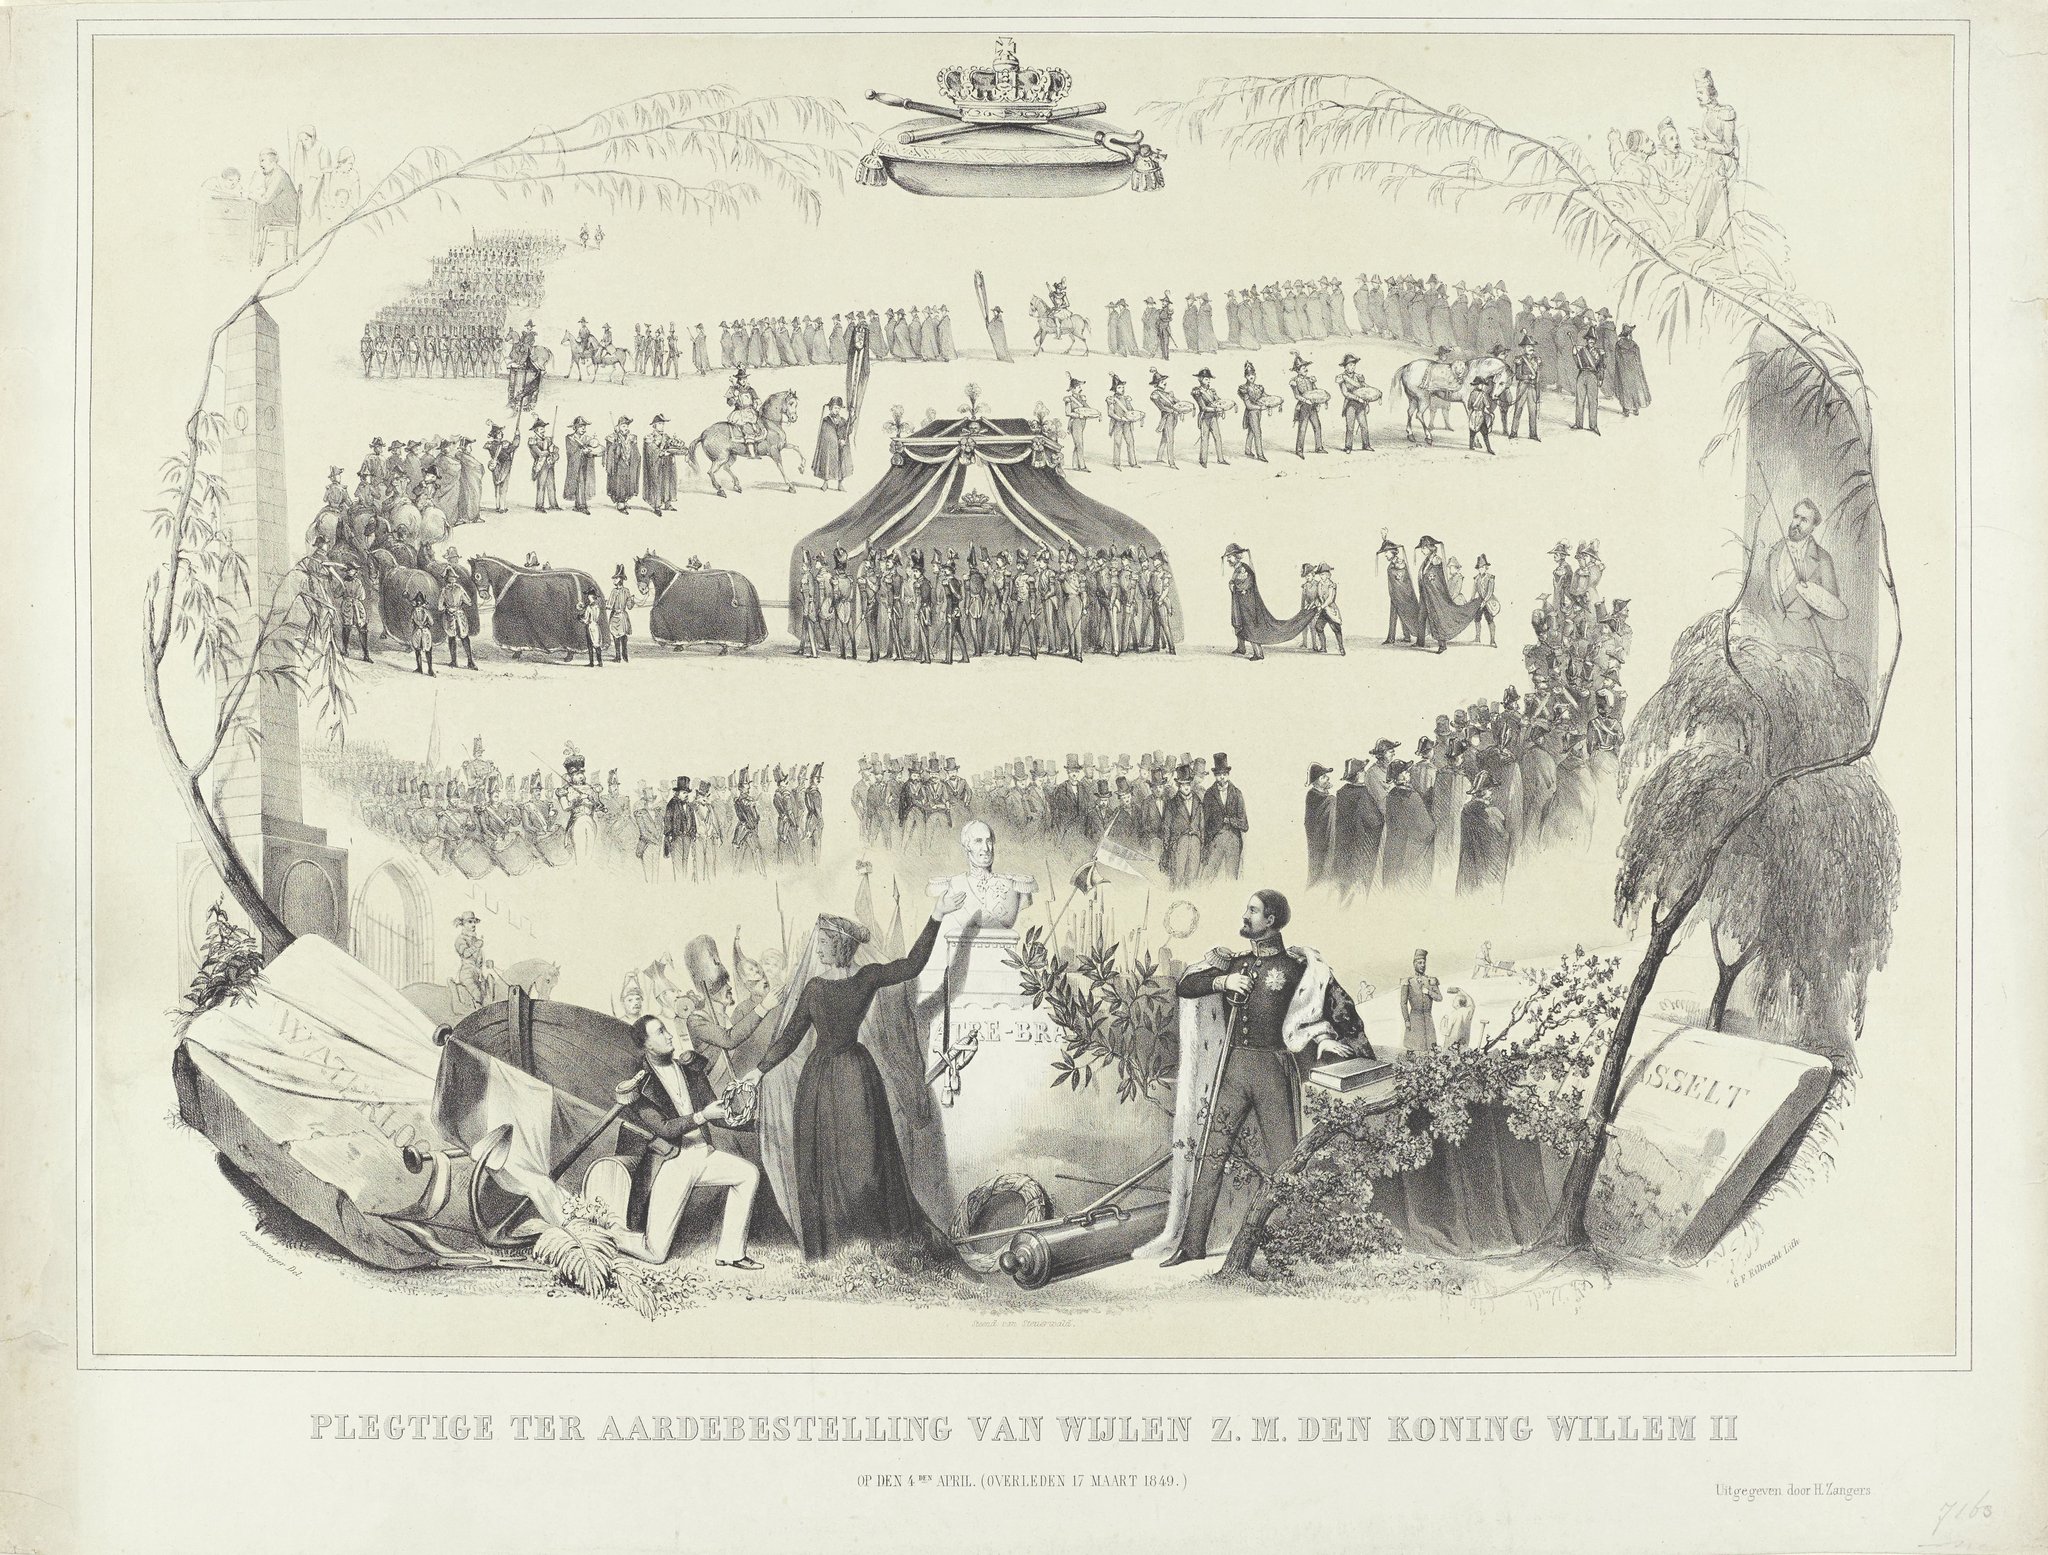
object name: print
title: Plegtige ter aardebestelling van wijlen Z.M. den Koning Willem II op den 4den april. (overleden 17 maart 1849.)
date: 1849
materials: paper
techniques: tone lithography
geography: netherlands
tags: anna paulowna romanowa, brussels, willem iii (koning der nederlanden), the hague, william ii of the netherlands, hendrik (prins der nederlanden), cortege, funeral procession, delft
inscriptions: collector's mark: Lugt 2228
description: Begrafenis van wijlen koning Willem II te Delft op 4 april 1849. Centraal de begrafenisstoet in vier rijen, onderaan de gesluierde weduwe bij een buste van haar man, links van haar knielt prins Hendrik, rechts staat koning Willem III. Ook met enkele verwijzingen naar de slagen bij Waterloo en Hasselt. Rechts in de marge heeft de tekenaar zich als schilder afgebeeld. Bij de prent behoort een aparte sleutel.